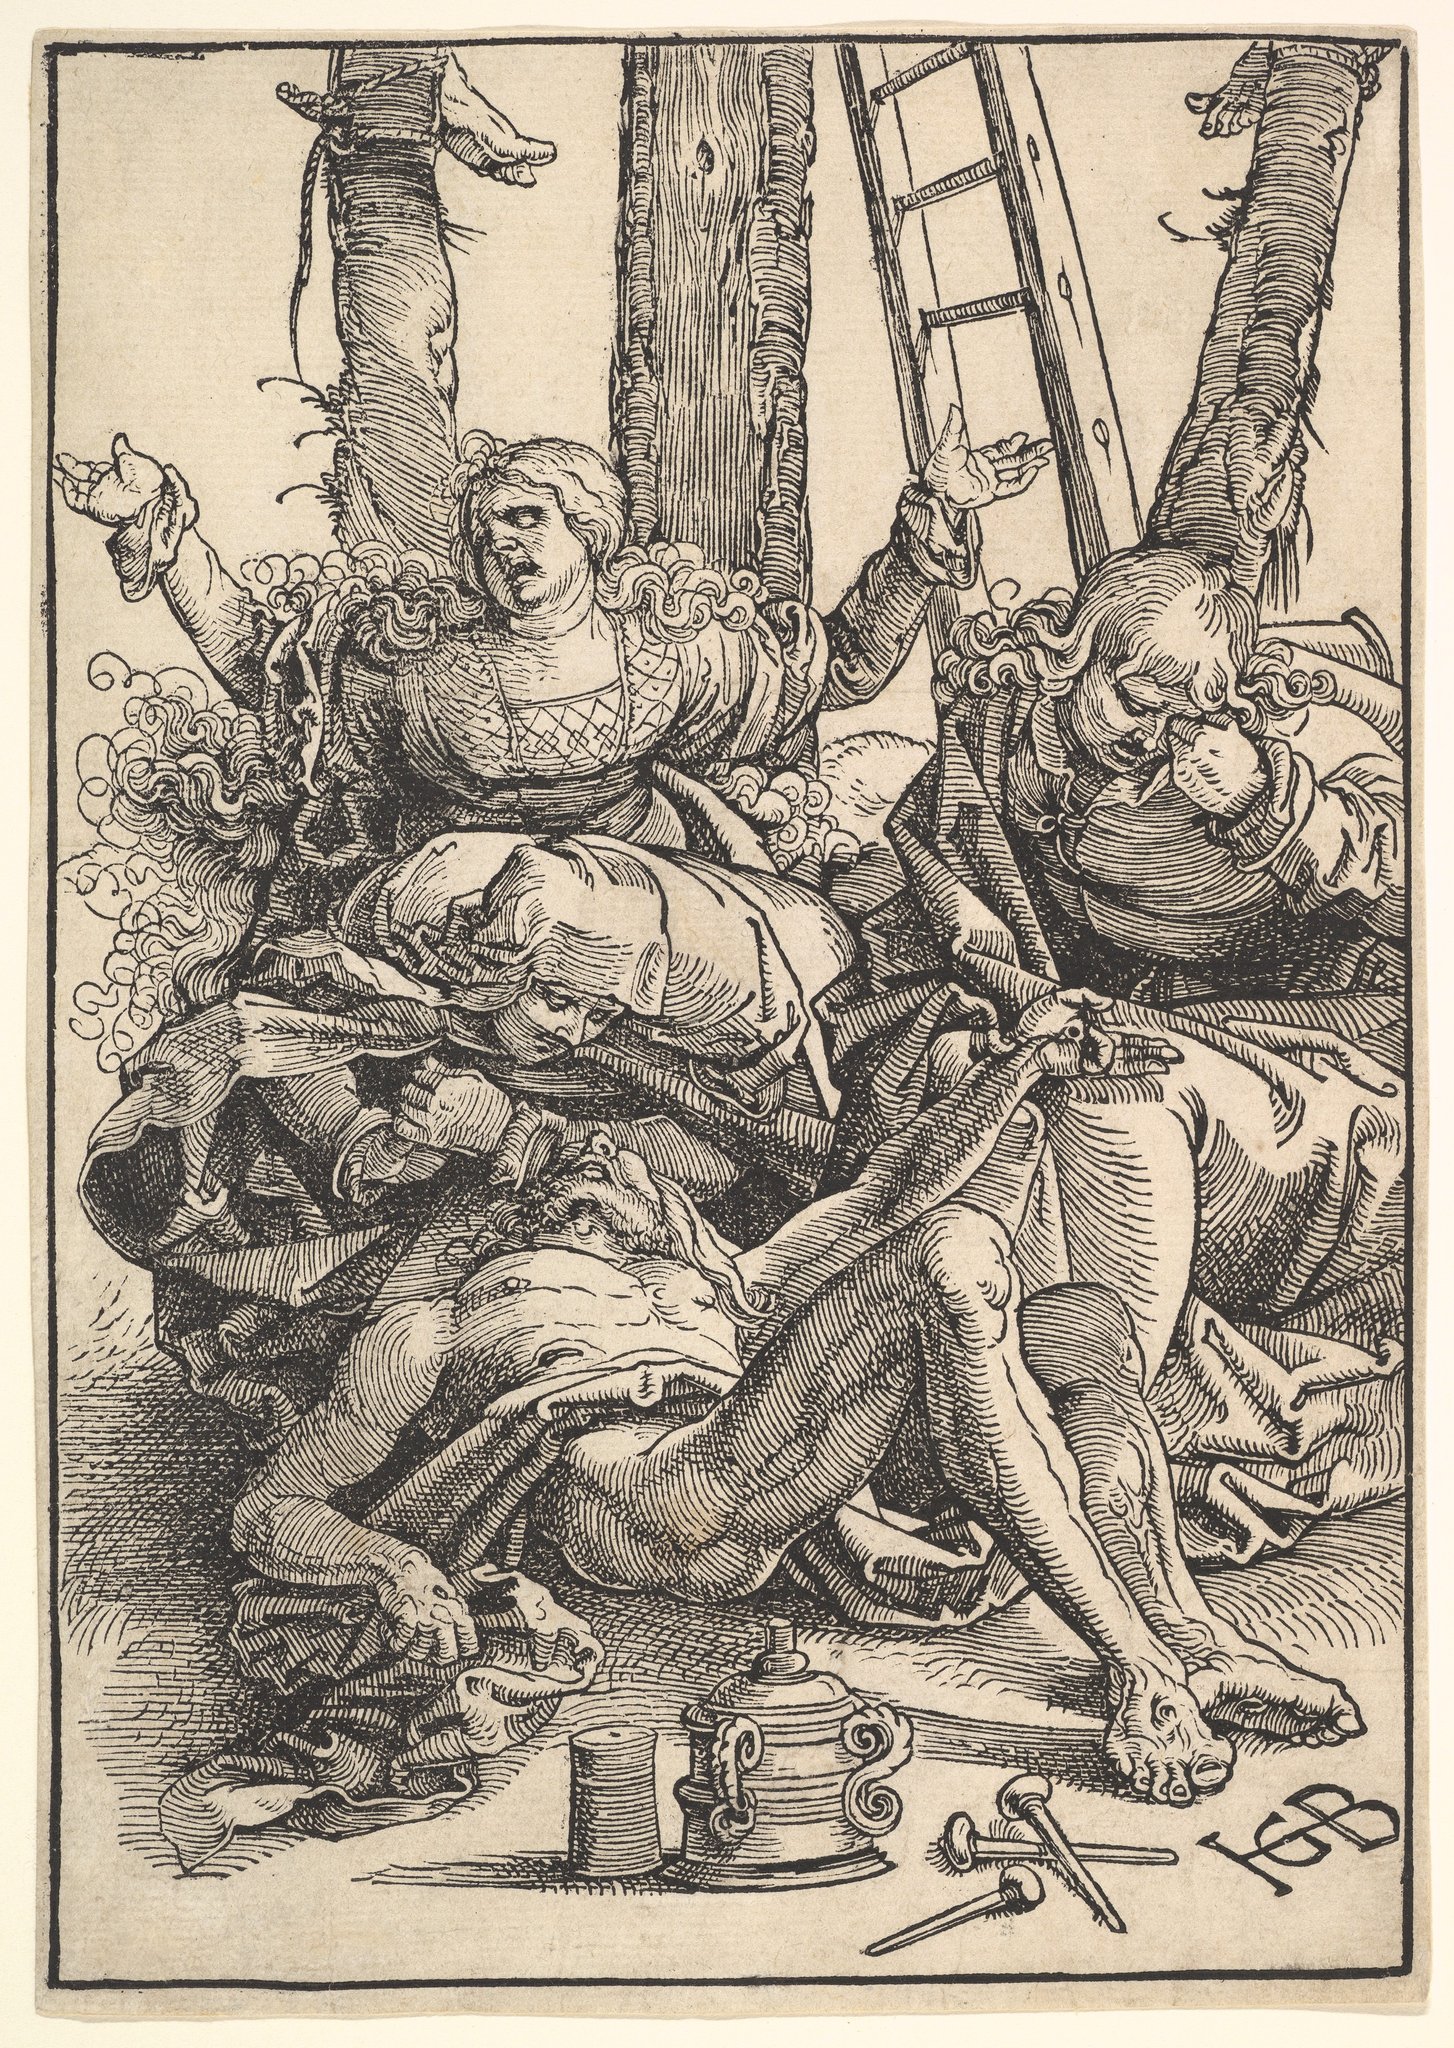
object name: print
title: Lamentation for Christ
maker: hans baldung (called hans baldung grien)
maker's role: artist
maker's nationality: german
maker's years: 1484-1545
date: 1510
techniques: woodcut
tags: christ,lamentation